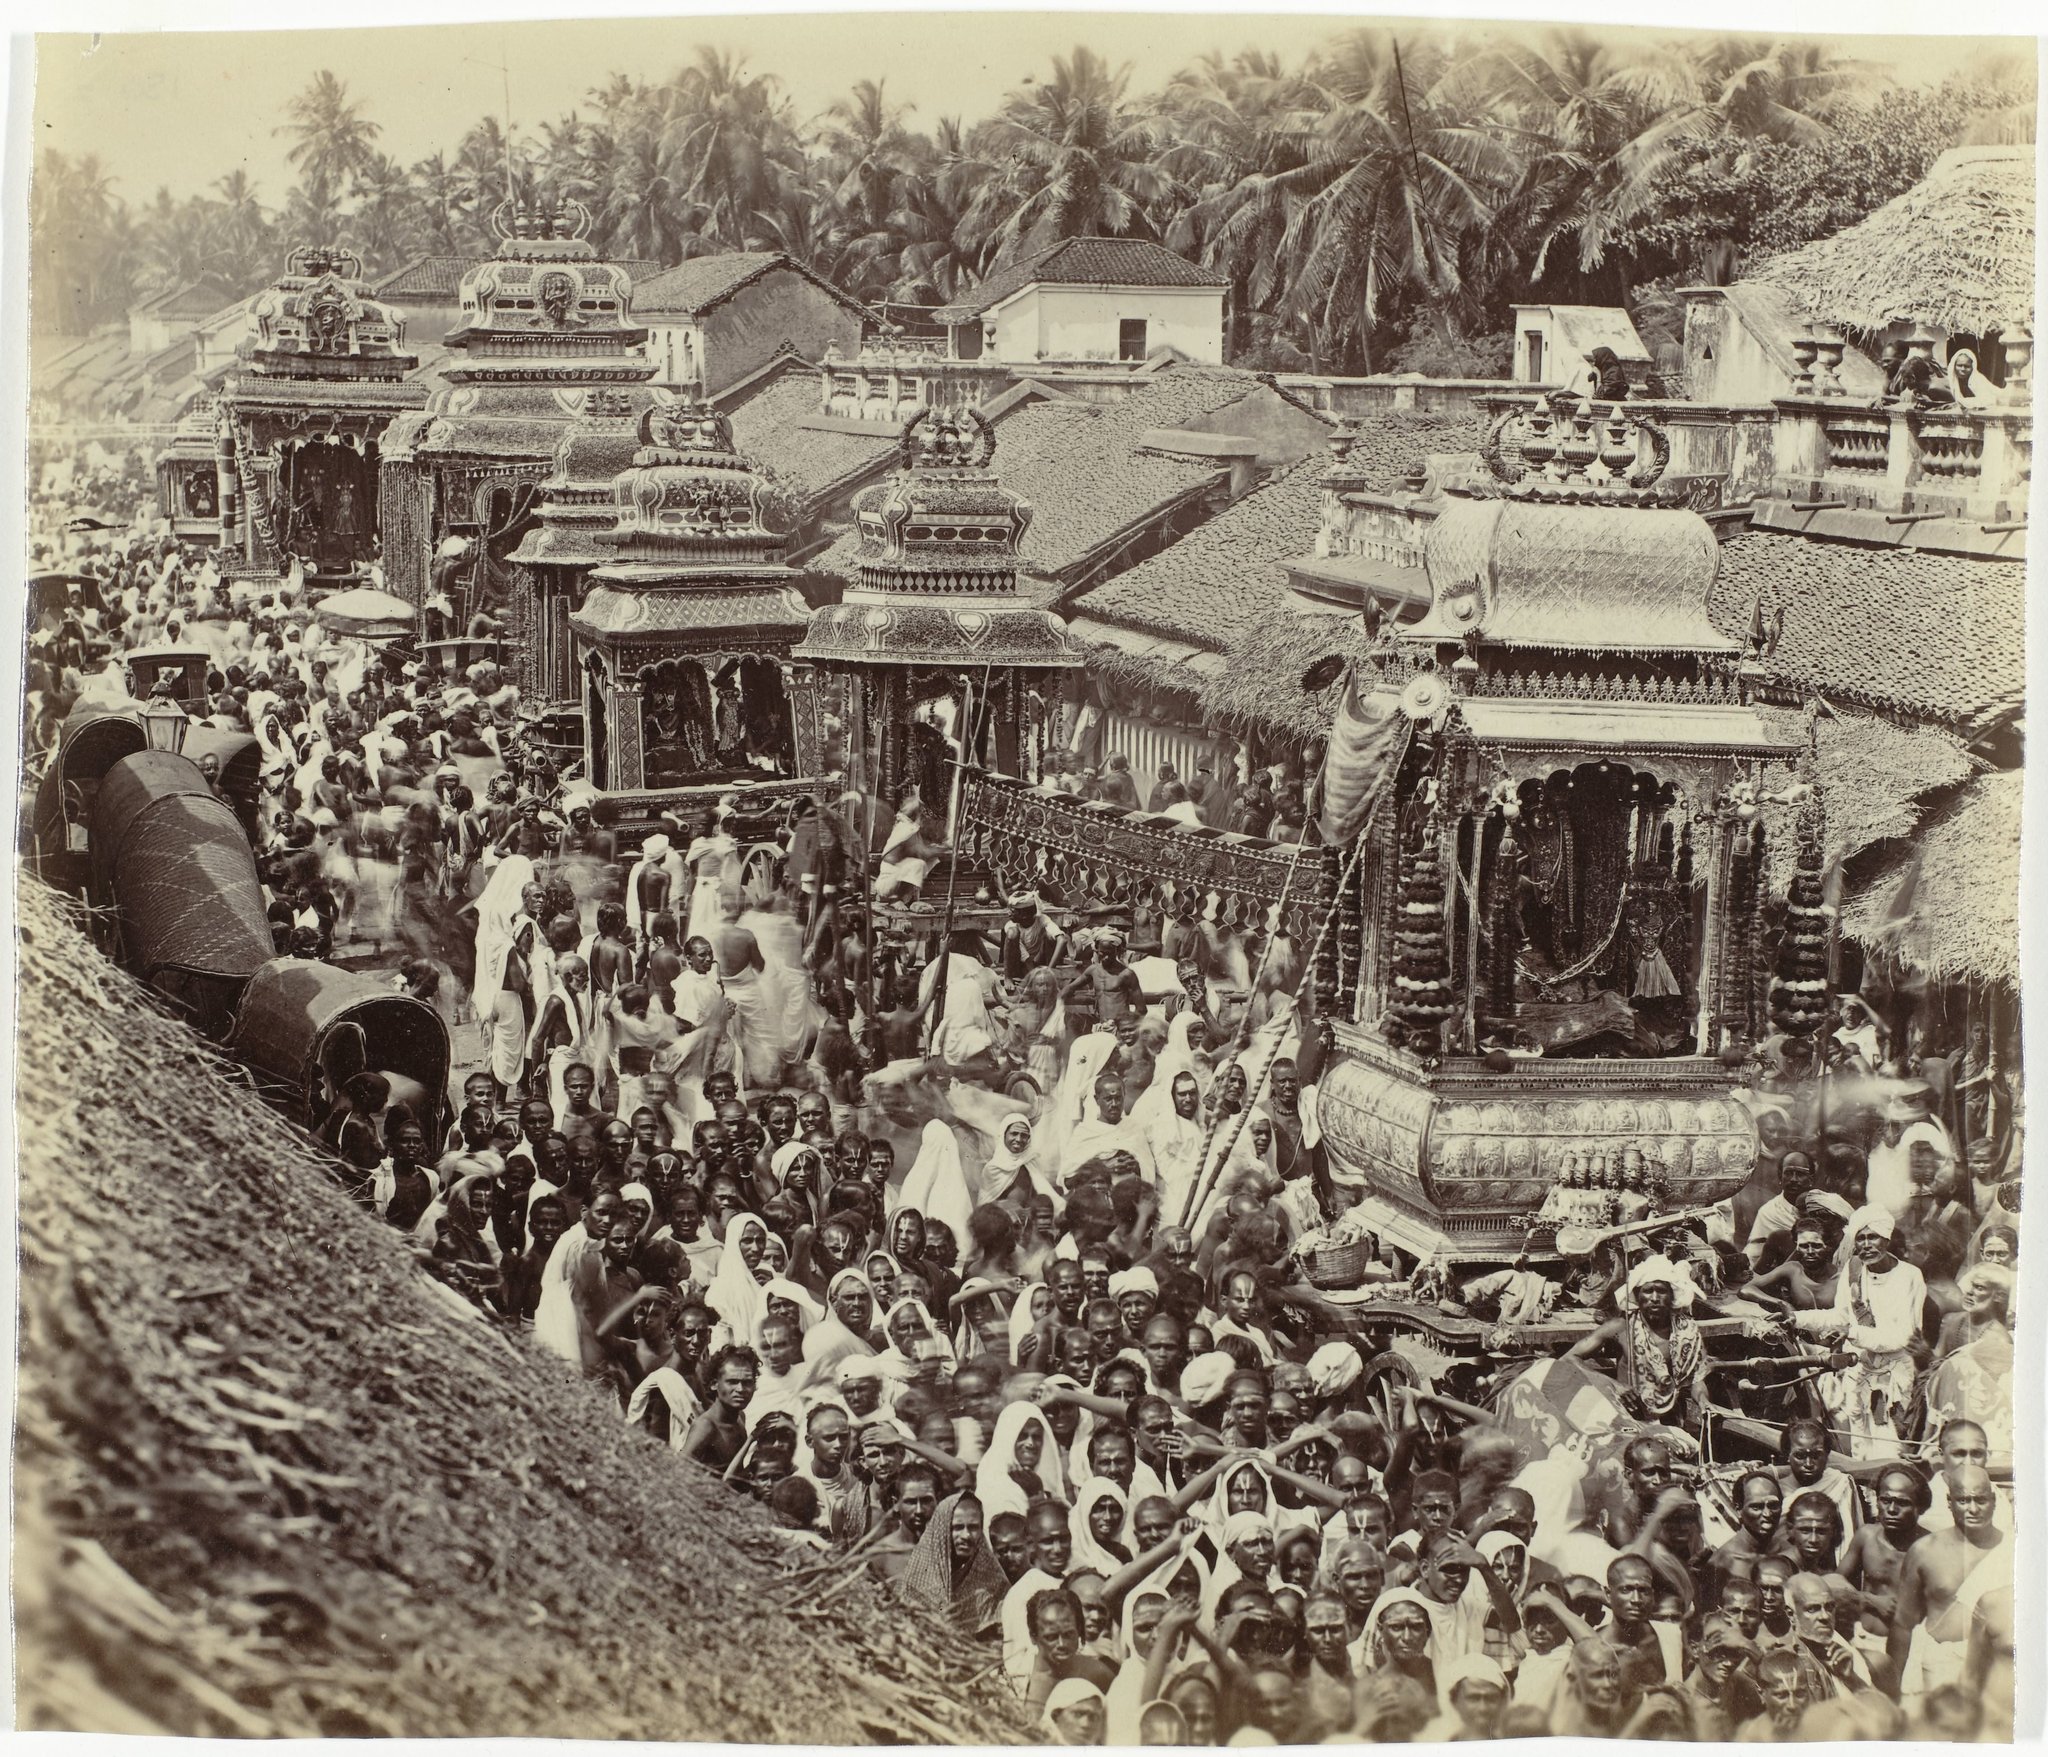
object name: photograph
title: Ratha Yatra procession with decorated chariots in Madurai, Tamil Nadu, India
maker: samuel bourne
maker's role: fotograaf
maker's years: 1834-1912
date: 1869-1870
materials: paper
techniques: albumen print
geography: madurai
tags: ritual observances in daily life ~ hinduism, buddhism, jainism, festivities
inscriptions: inscription: ‘62/Jagannath Cars Madura/ Jagannath Cars/ Madura South India/ 1395. 2021’